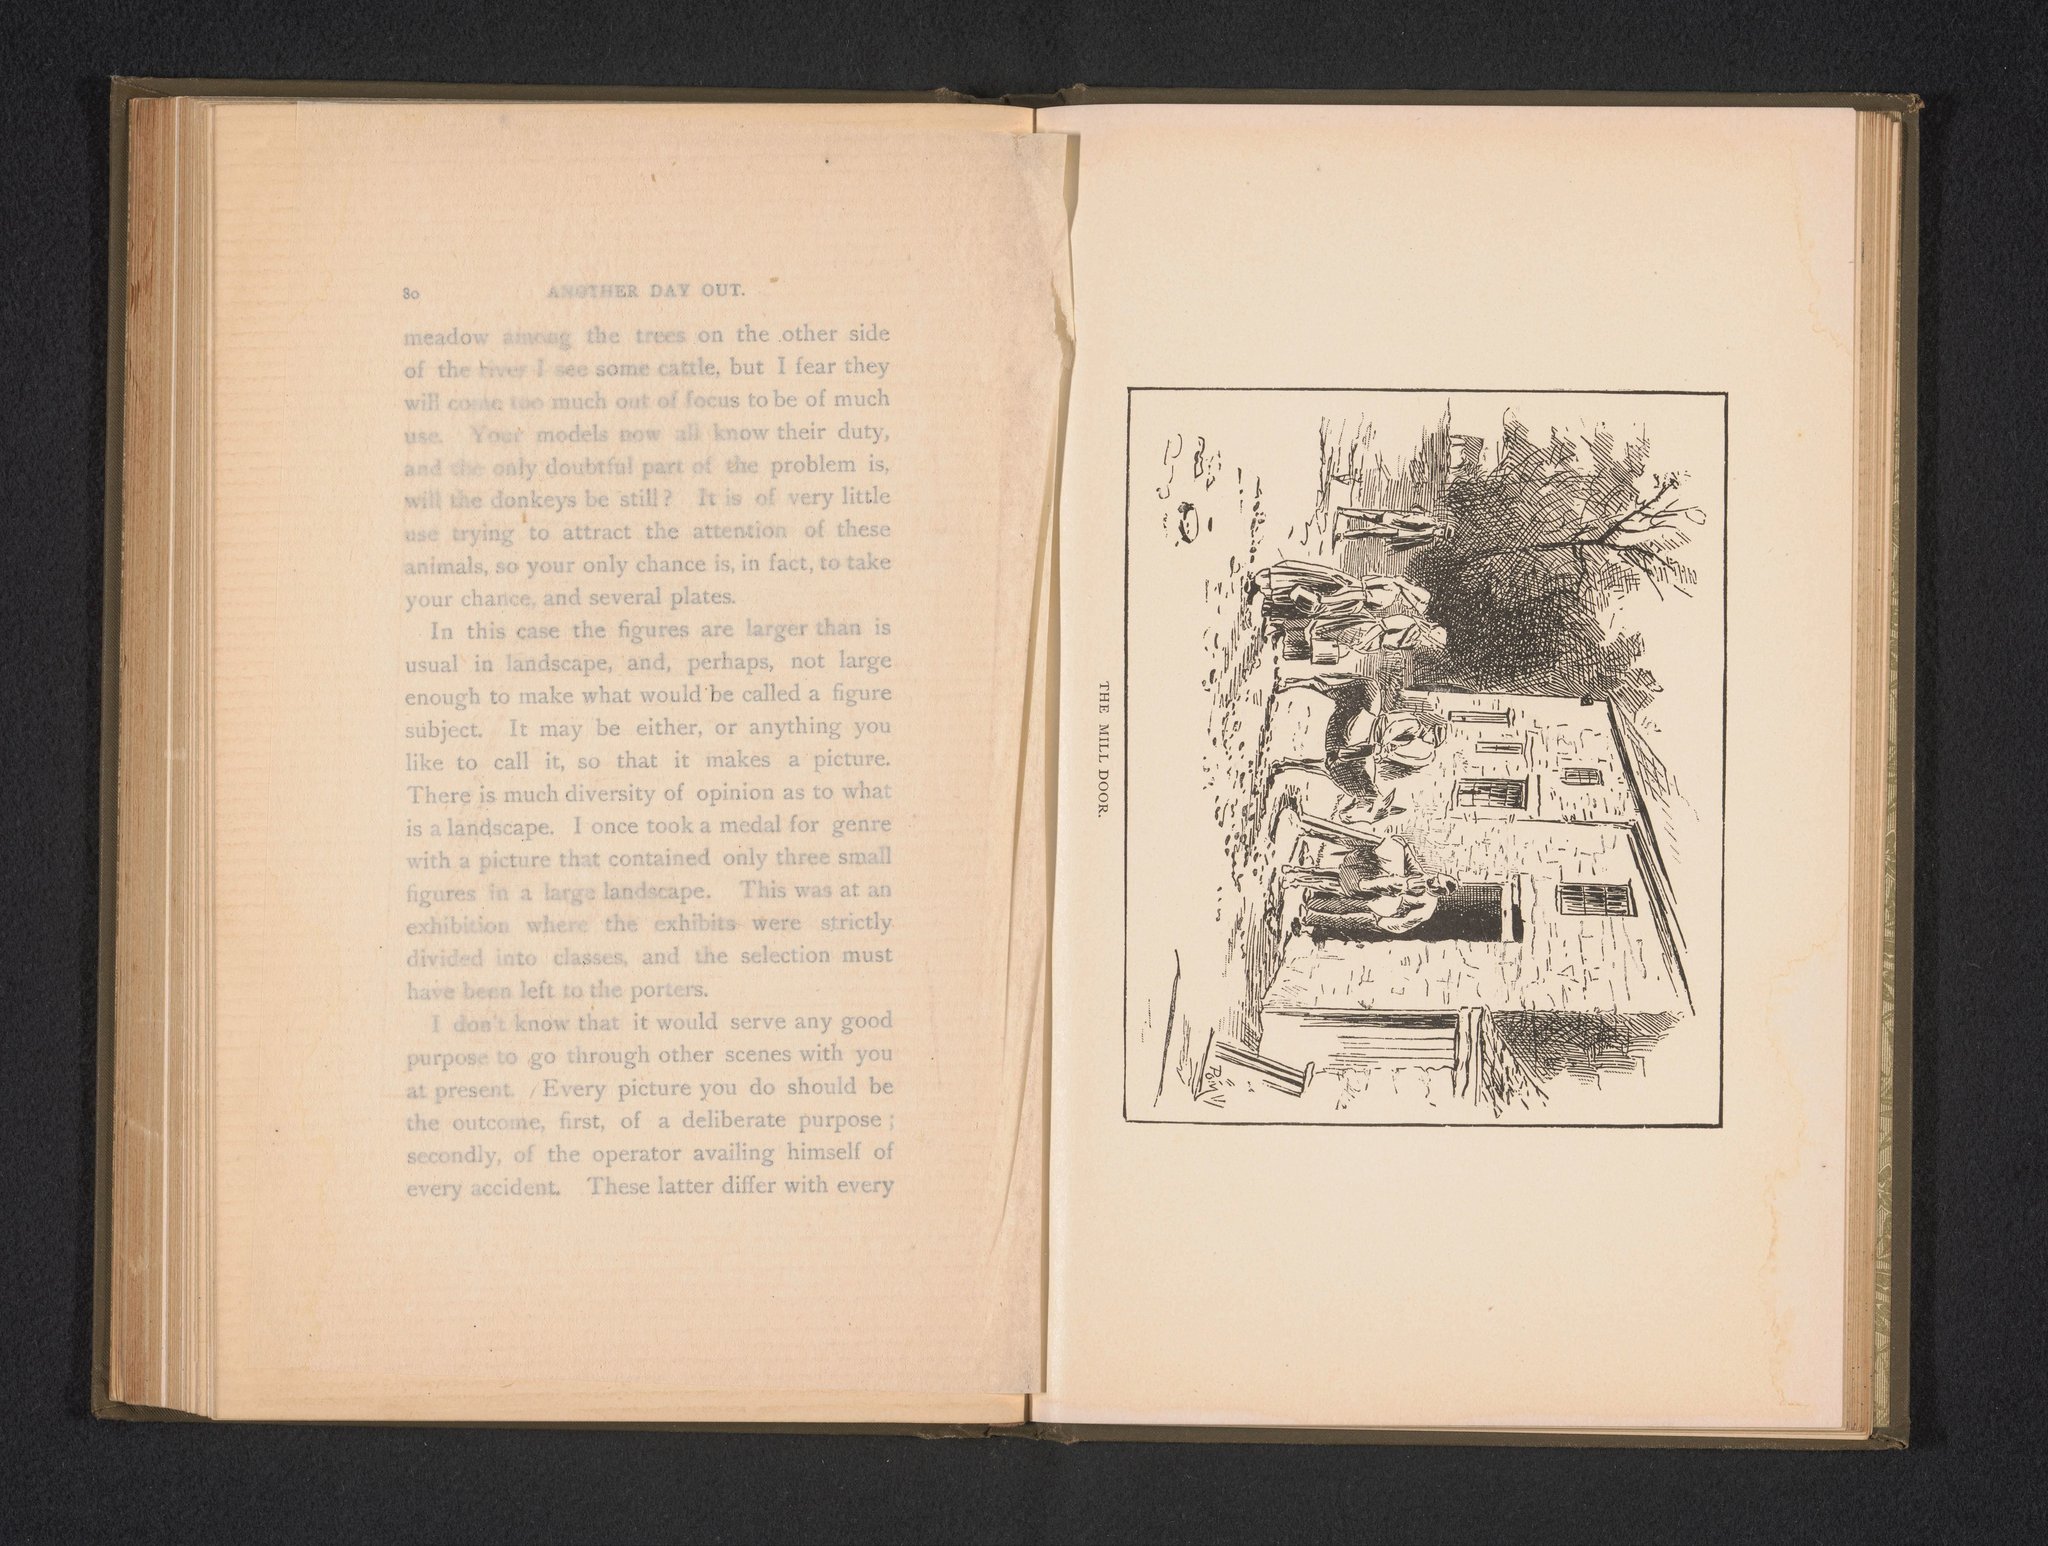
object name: reproduction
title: Fotoreproductie van een gezicht op een onbekende personen waarvan één een deur opent en een ezel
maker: Anonymous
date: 1883-1888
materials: paper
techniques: autotype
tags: open door, historical persons (portraits and scenes from the life), donkey-riding (on the beach)